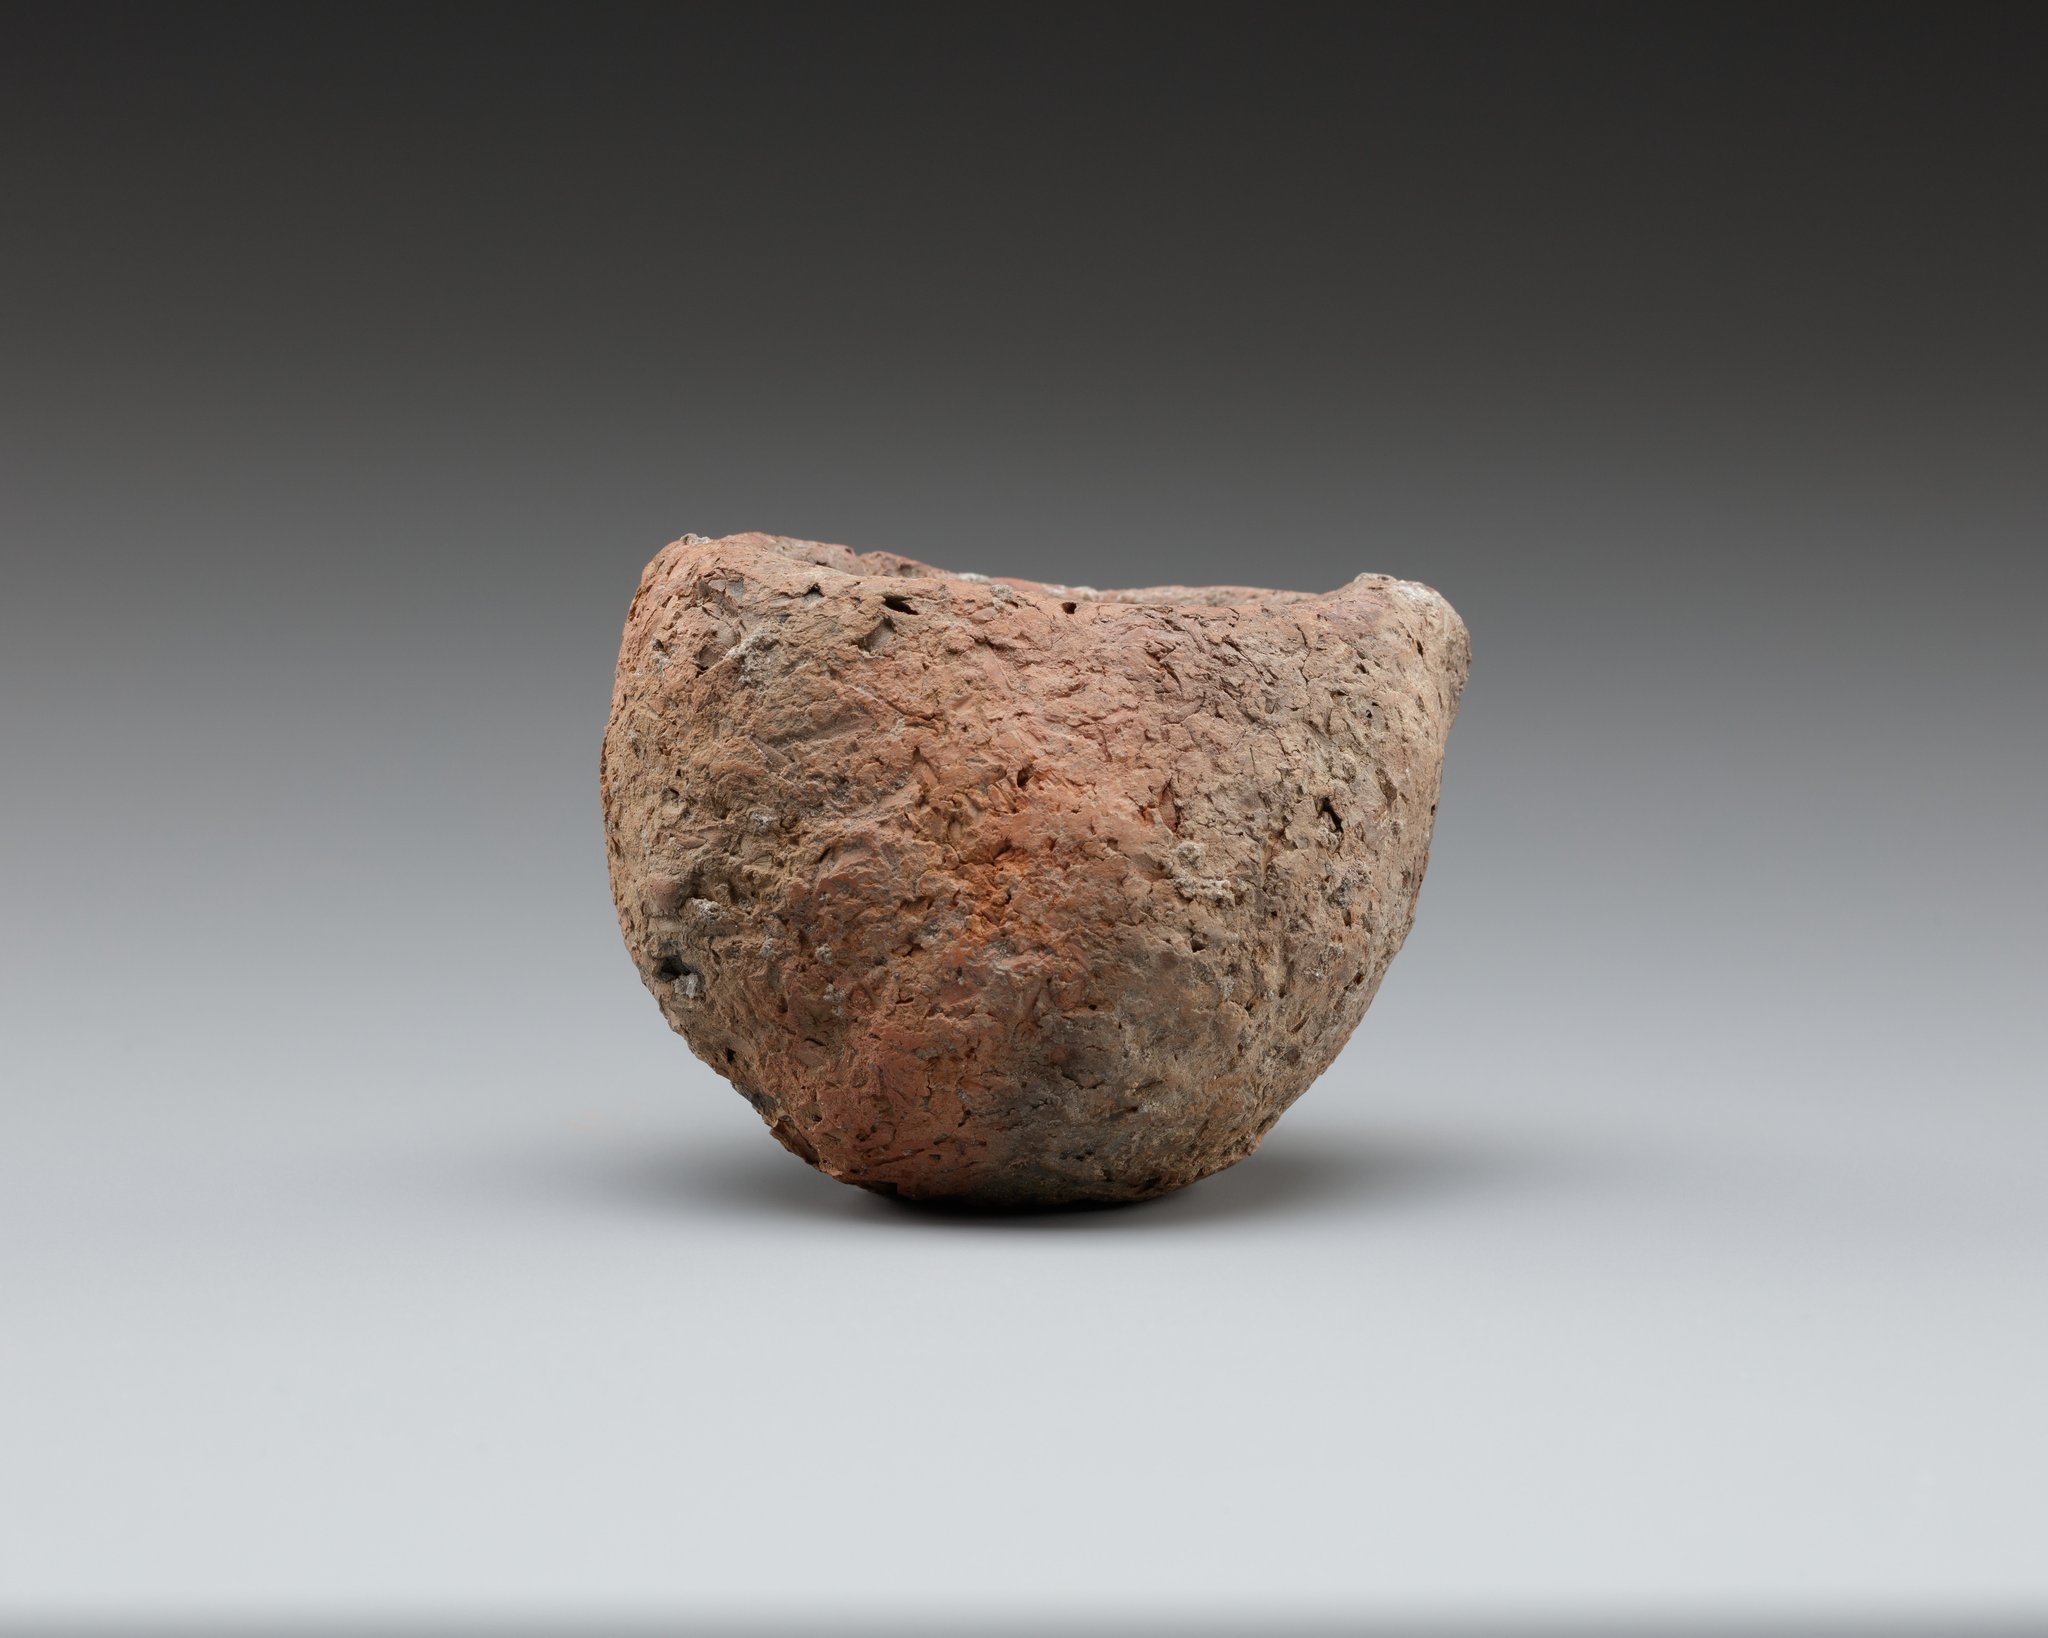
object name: bowl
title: Tiny bowl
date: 4500-4000 BCE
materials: pottery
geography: egypt